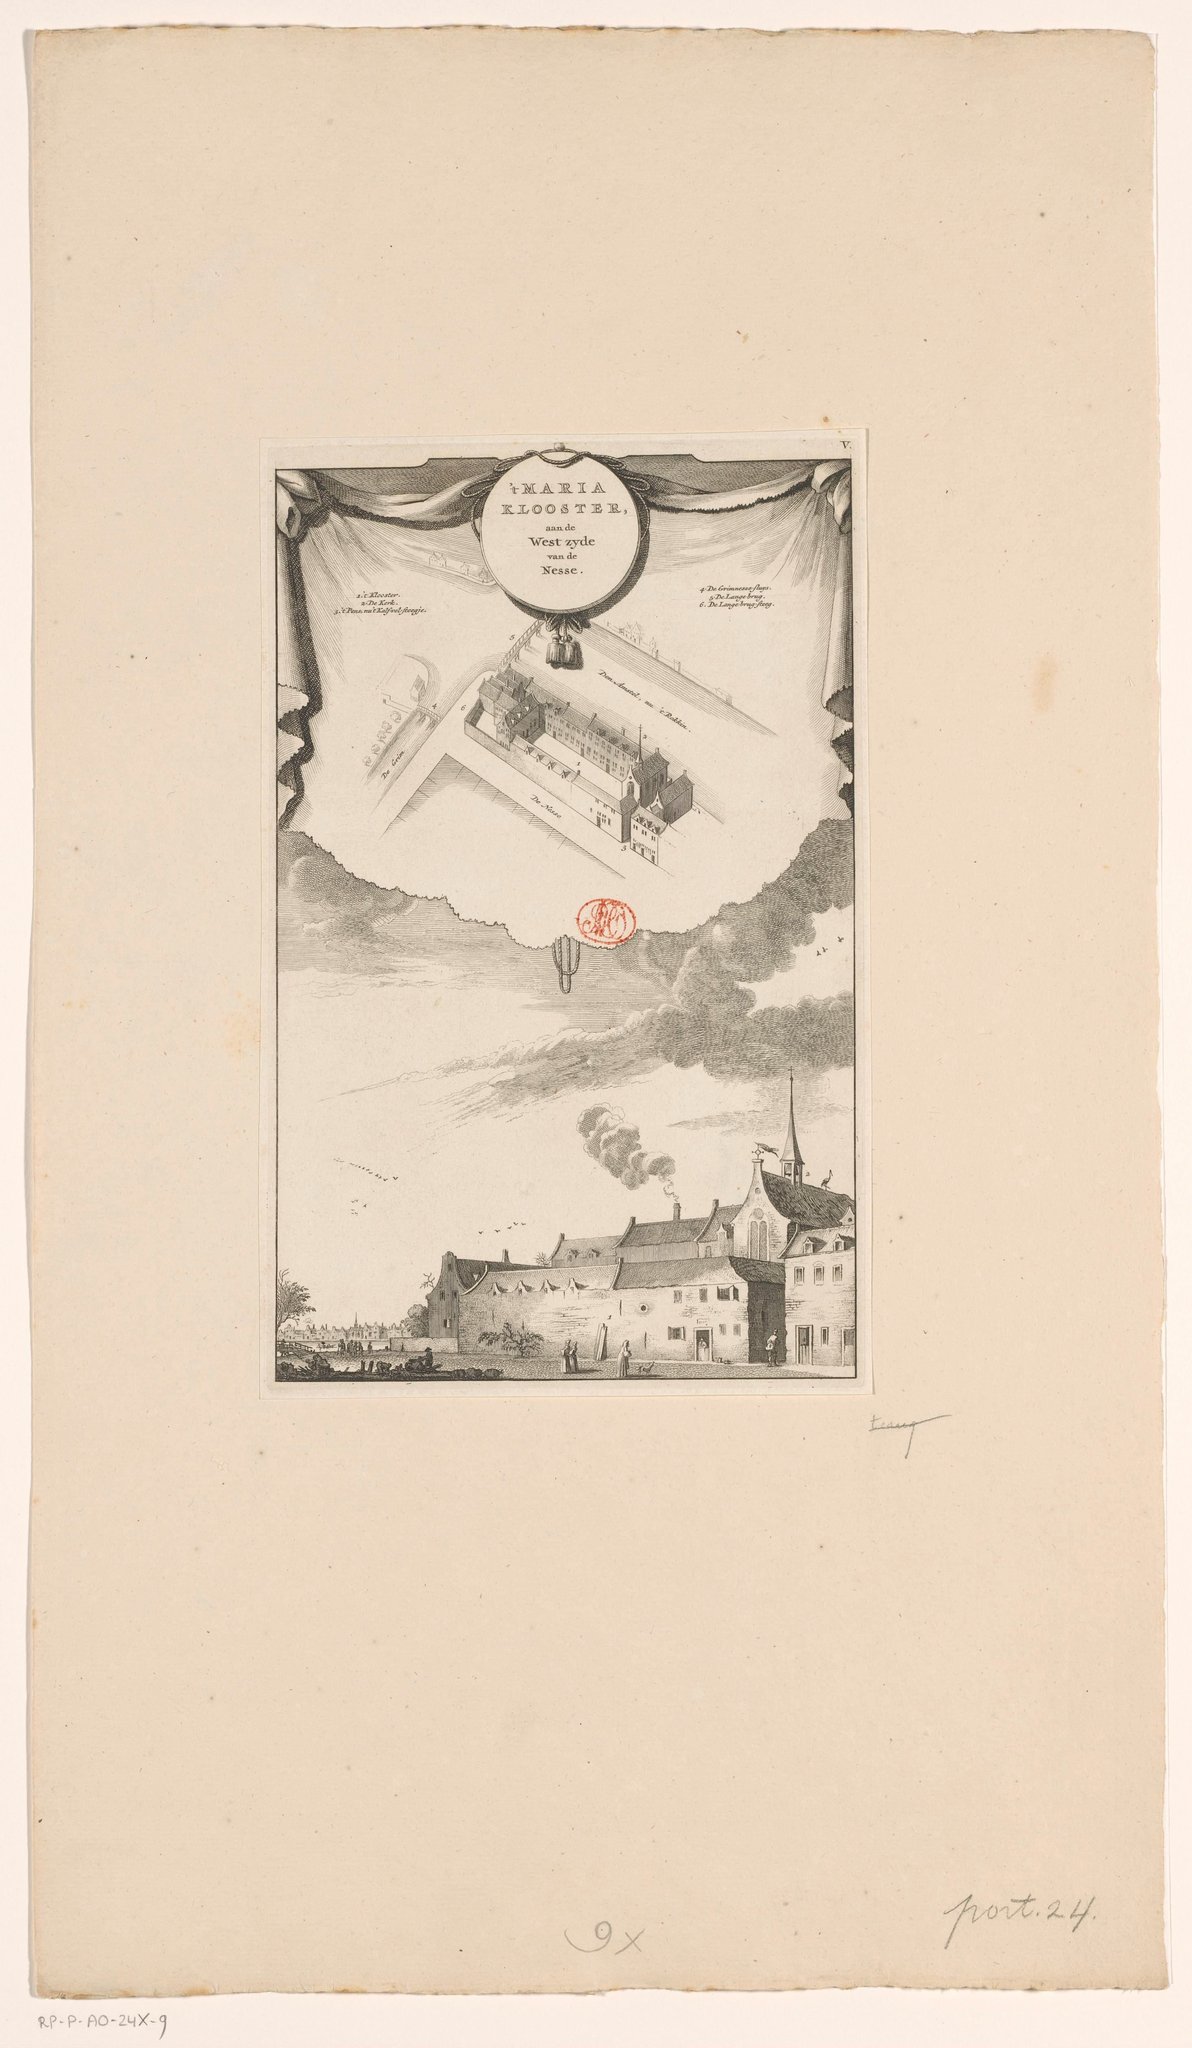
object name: print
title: 't Maria Klooster, aan de West zyde van de Nesse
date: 1760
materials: paper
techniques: engraving, etching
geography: amsterdam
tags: abbey, monastery, convent ~ roman catholic church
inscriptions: collector's mark: Lugt 2233, collector's mark: Lugt 195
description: Prent ook gebruikt in: Wagenaar, Jan. Amsterdam, in zyne opkomst, aanwas, geschiedenissen (…). 3 delen [folio-uitgave]. Amsterdam: Isaak Tirion en Yntema & Tieboel, 1760-1767, dl. 1 (Isaac Tirion, 1760). Zie RP-P-AO-24X-10 voor proefdruk. Dat de prent de situatie rond 1544 weergeeft gaat terug op het feit dat voor het maken van deze en andere prenten van kloosters en kerken van voor de Alteratie (1578) is uitgegaan van de plattegrond van Cornelis Anthonisz. uit 1544 (zie RP-P-OB-70.399 en RP-P-AO-20-15).